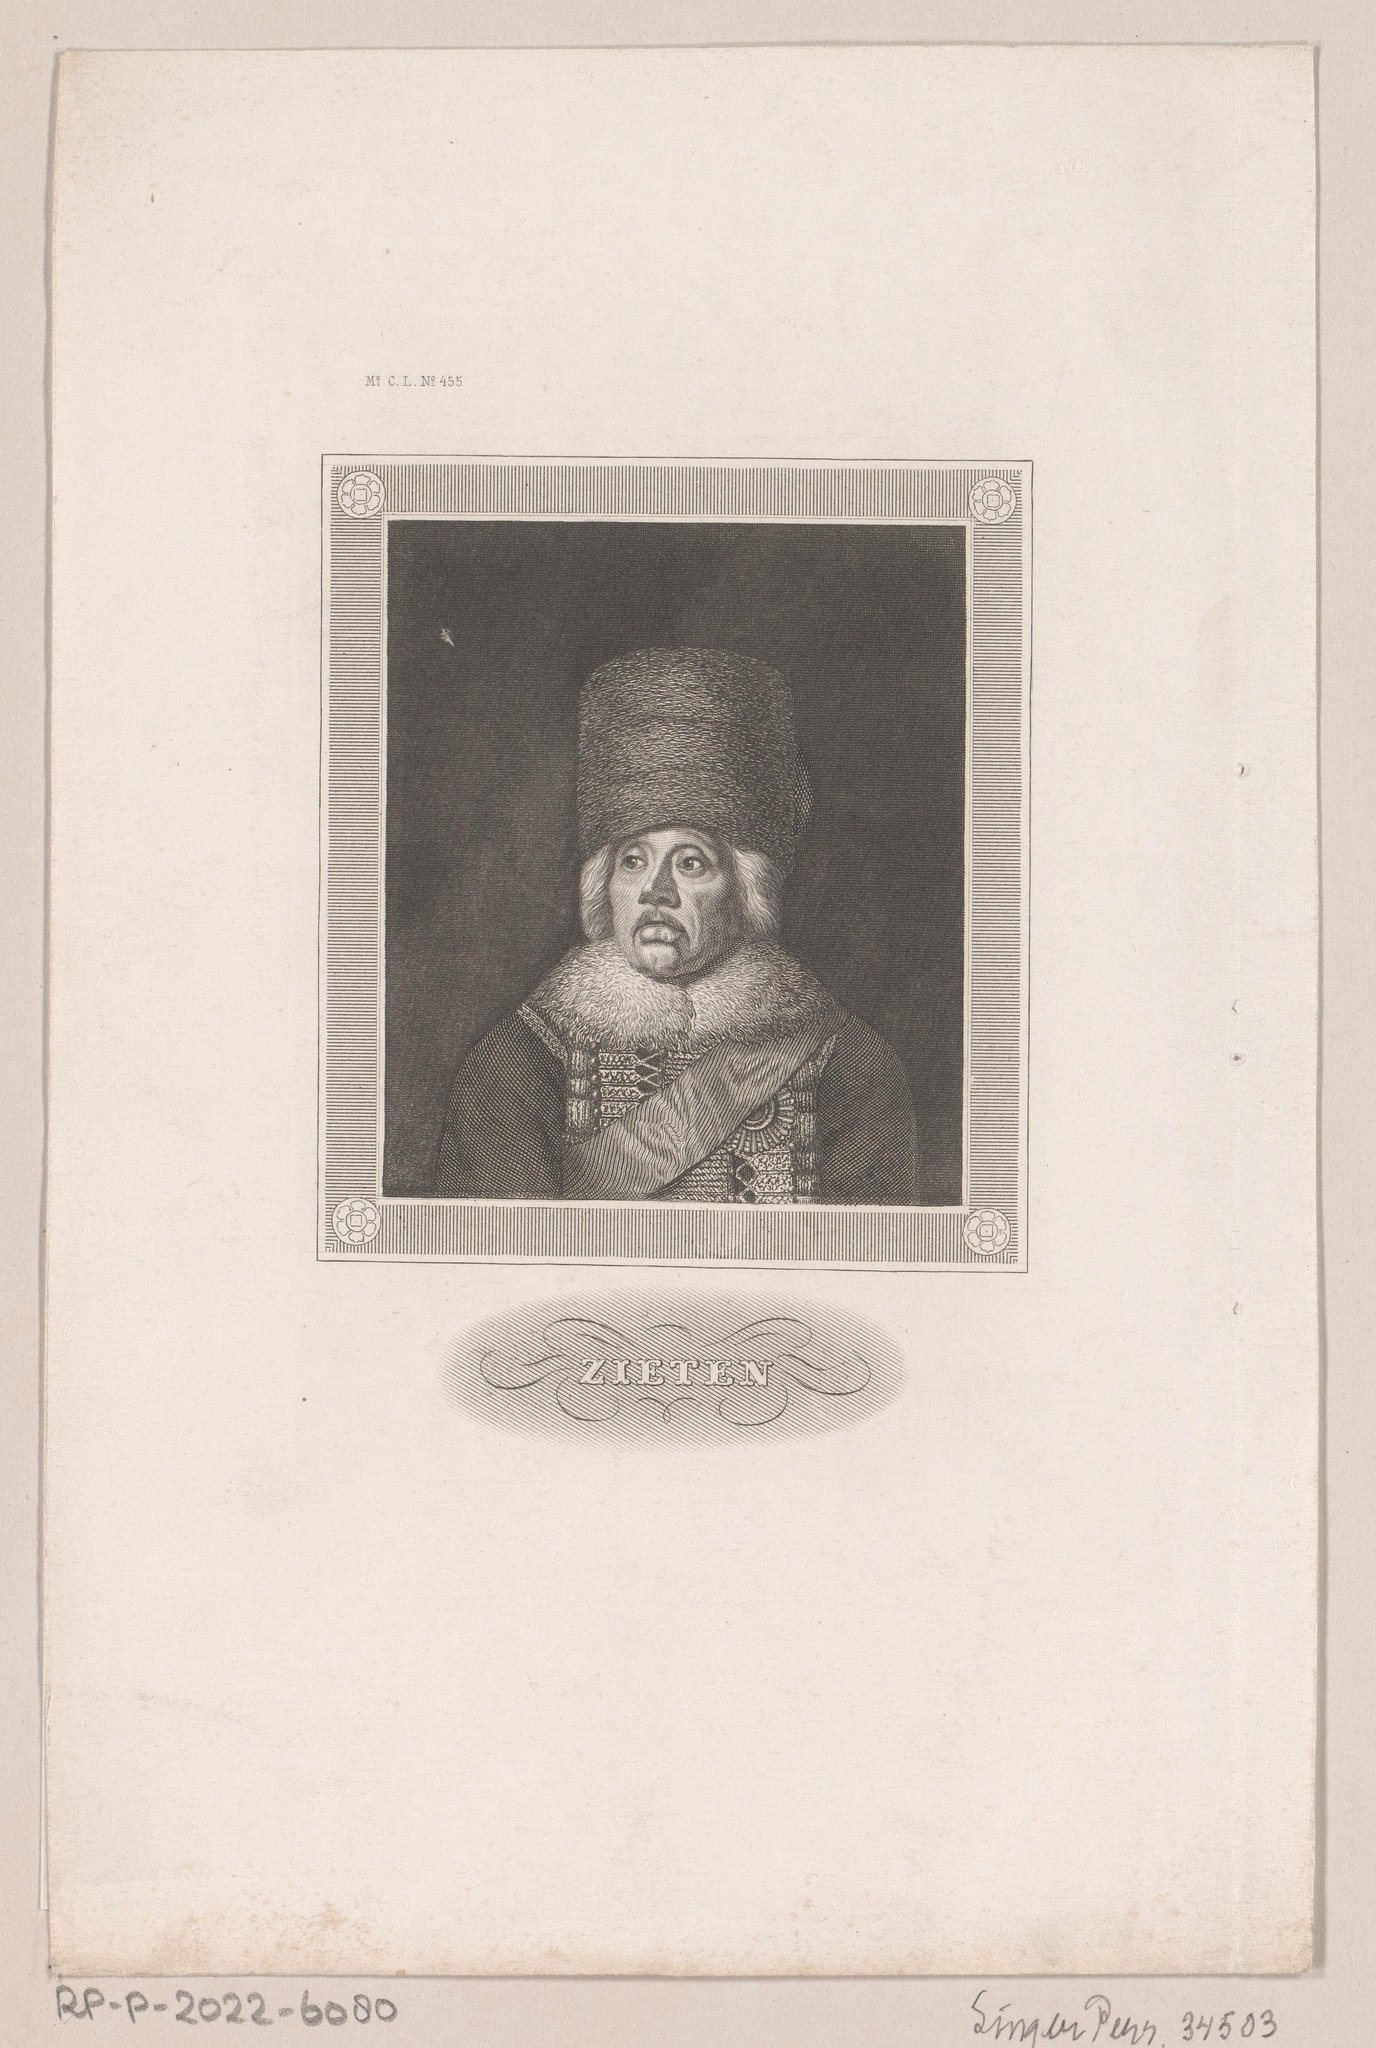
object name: print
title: Portret van Hans Joachim von Zieten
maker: Anonymous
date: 1840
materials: paper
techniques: engraving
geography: germany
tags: berlin, commander-in-chief, general, marshal, historical persons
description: Prent waarschijnlijk uit: Meyer, Joseph. Das große Conversations-Lexikon für die gebildeten Stände. Hildburghausen: Bibliographisches Institut, 1840, dl. 4.